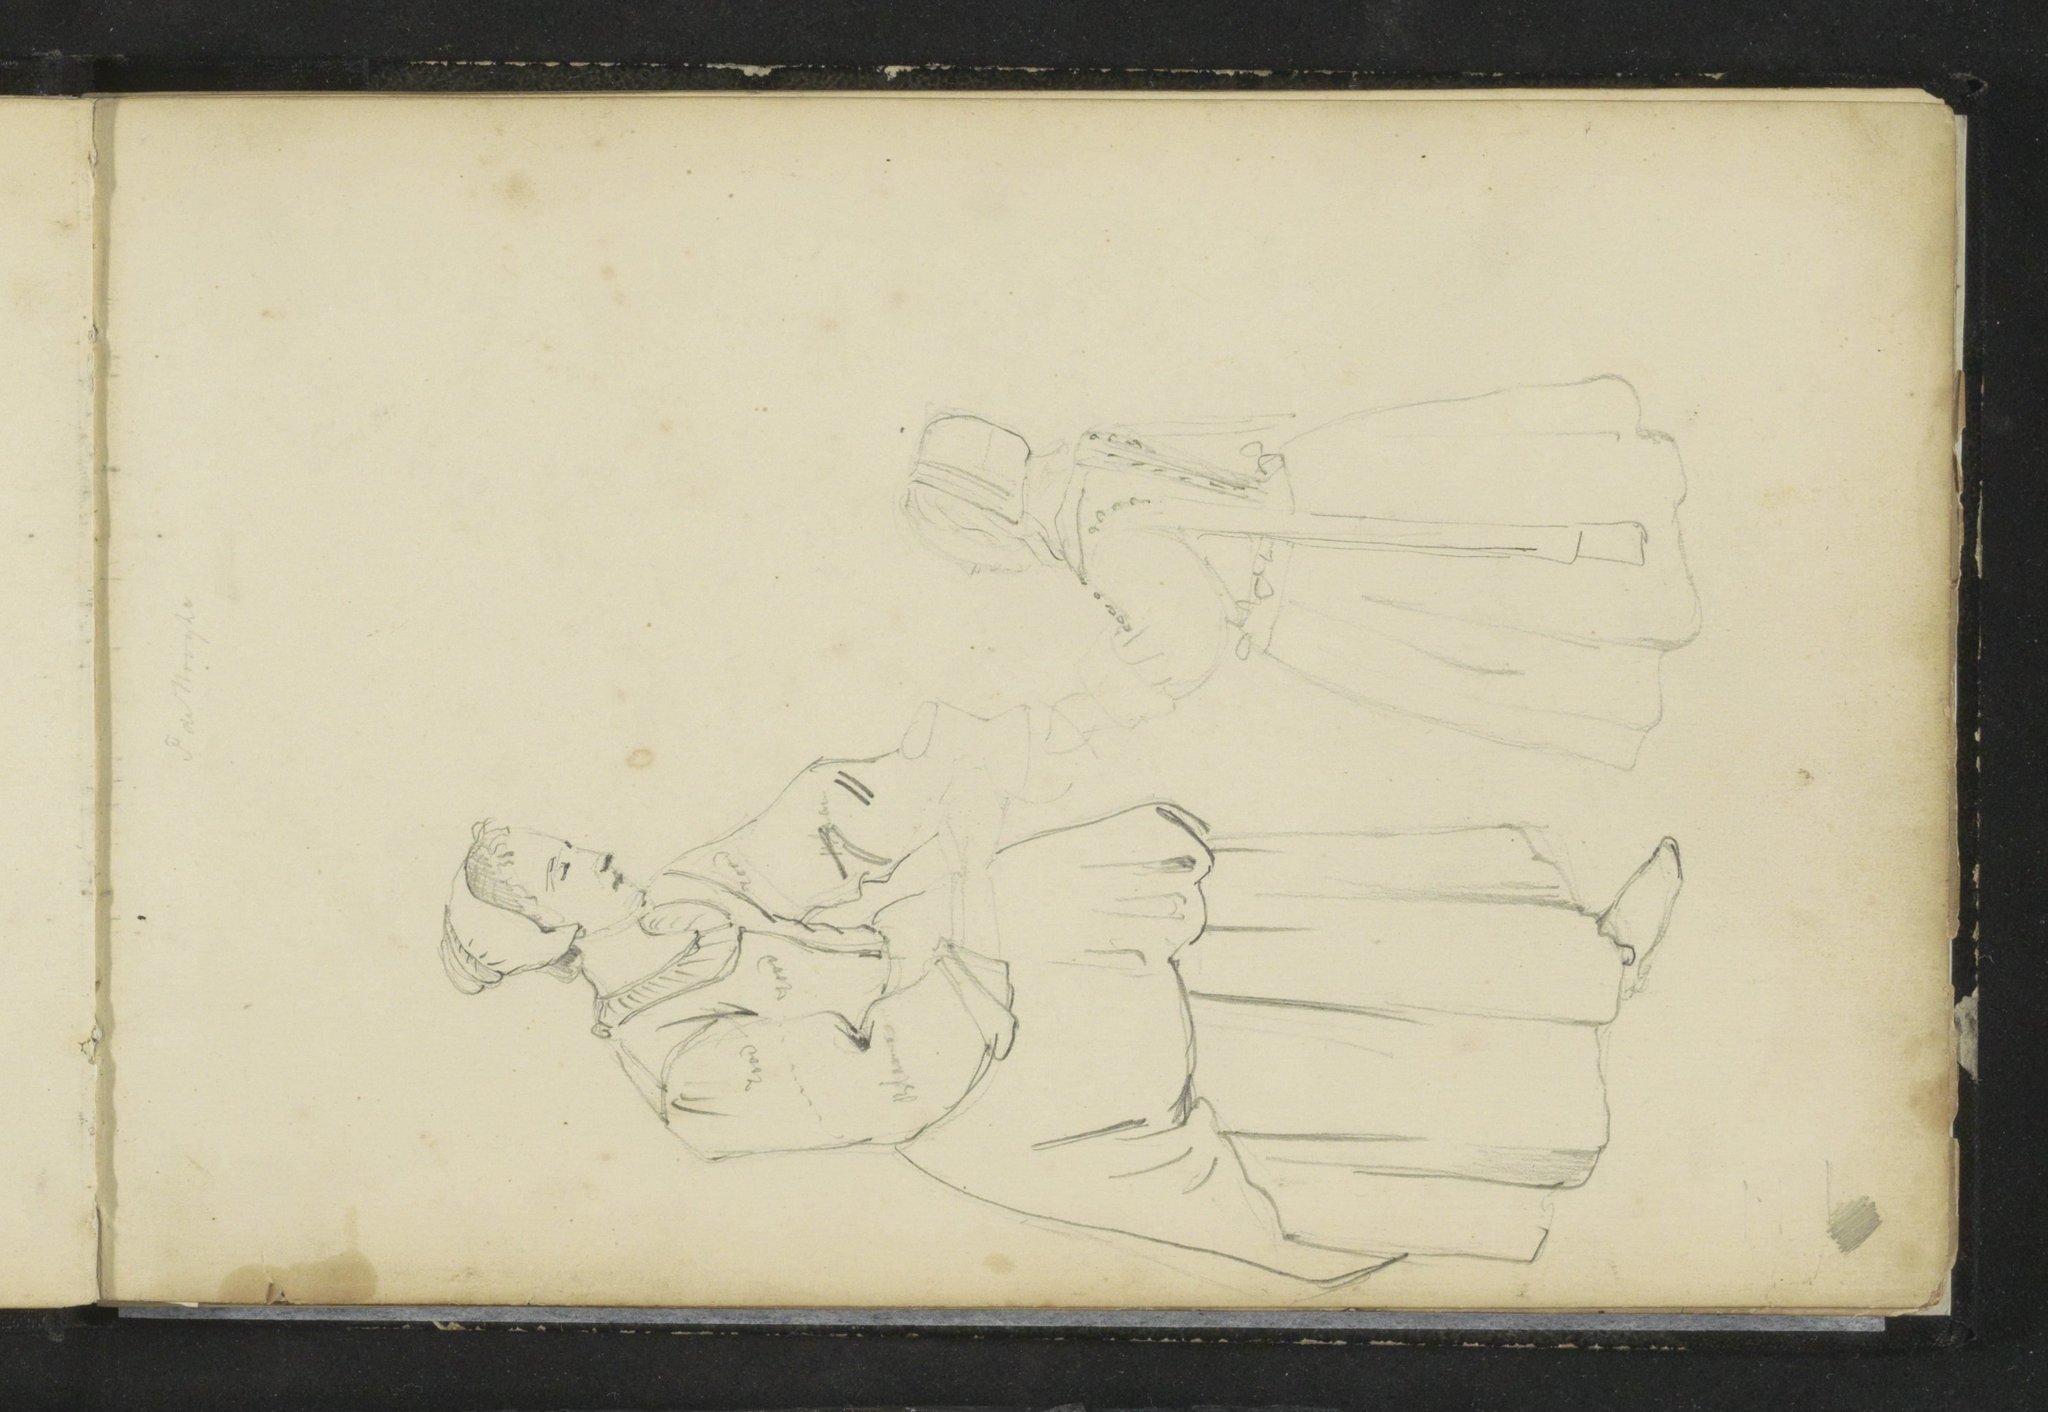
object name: sketchbook leaf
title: Vrouw reikt een meisje een kan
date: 1846-1882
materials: paper, pencil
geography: amsterdam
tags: adolescent, young woman, maiden, child (+ female (human being) (not to be used where -aa- is prescribed)), container of ceramics: jar, jug, pot, vase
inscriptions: annotation: ‘P. de Hooghe’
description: Een jonge vrouw reikt een meisje een kan met deksel. Blad 7 uit een schetsboek met 91 bladen.